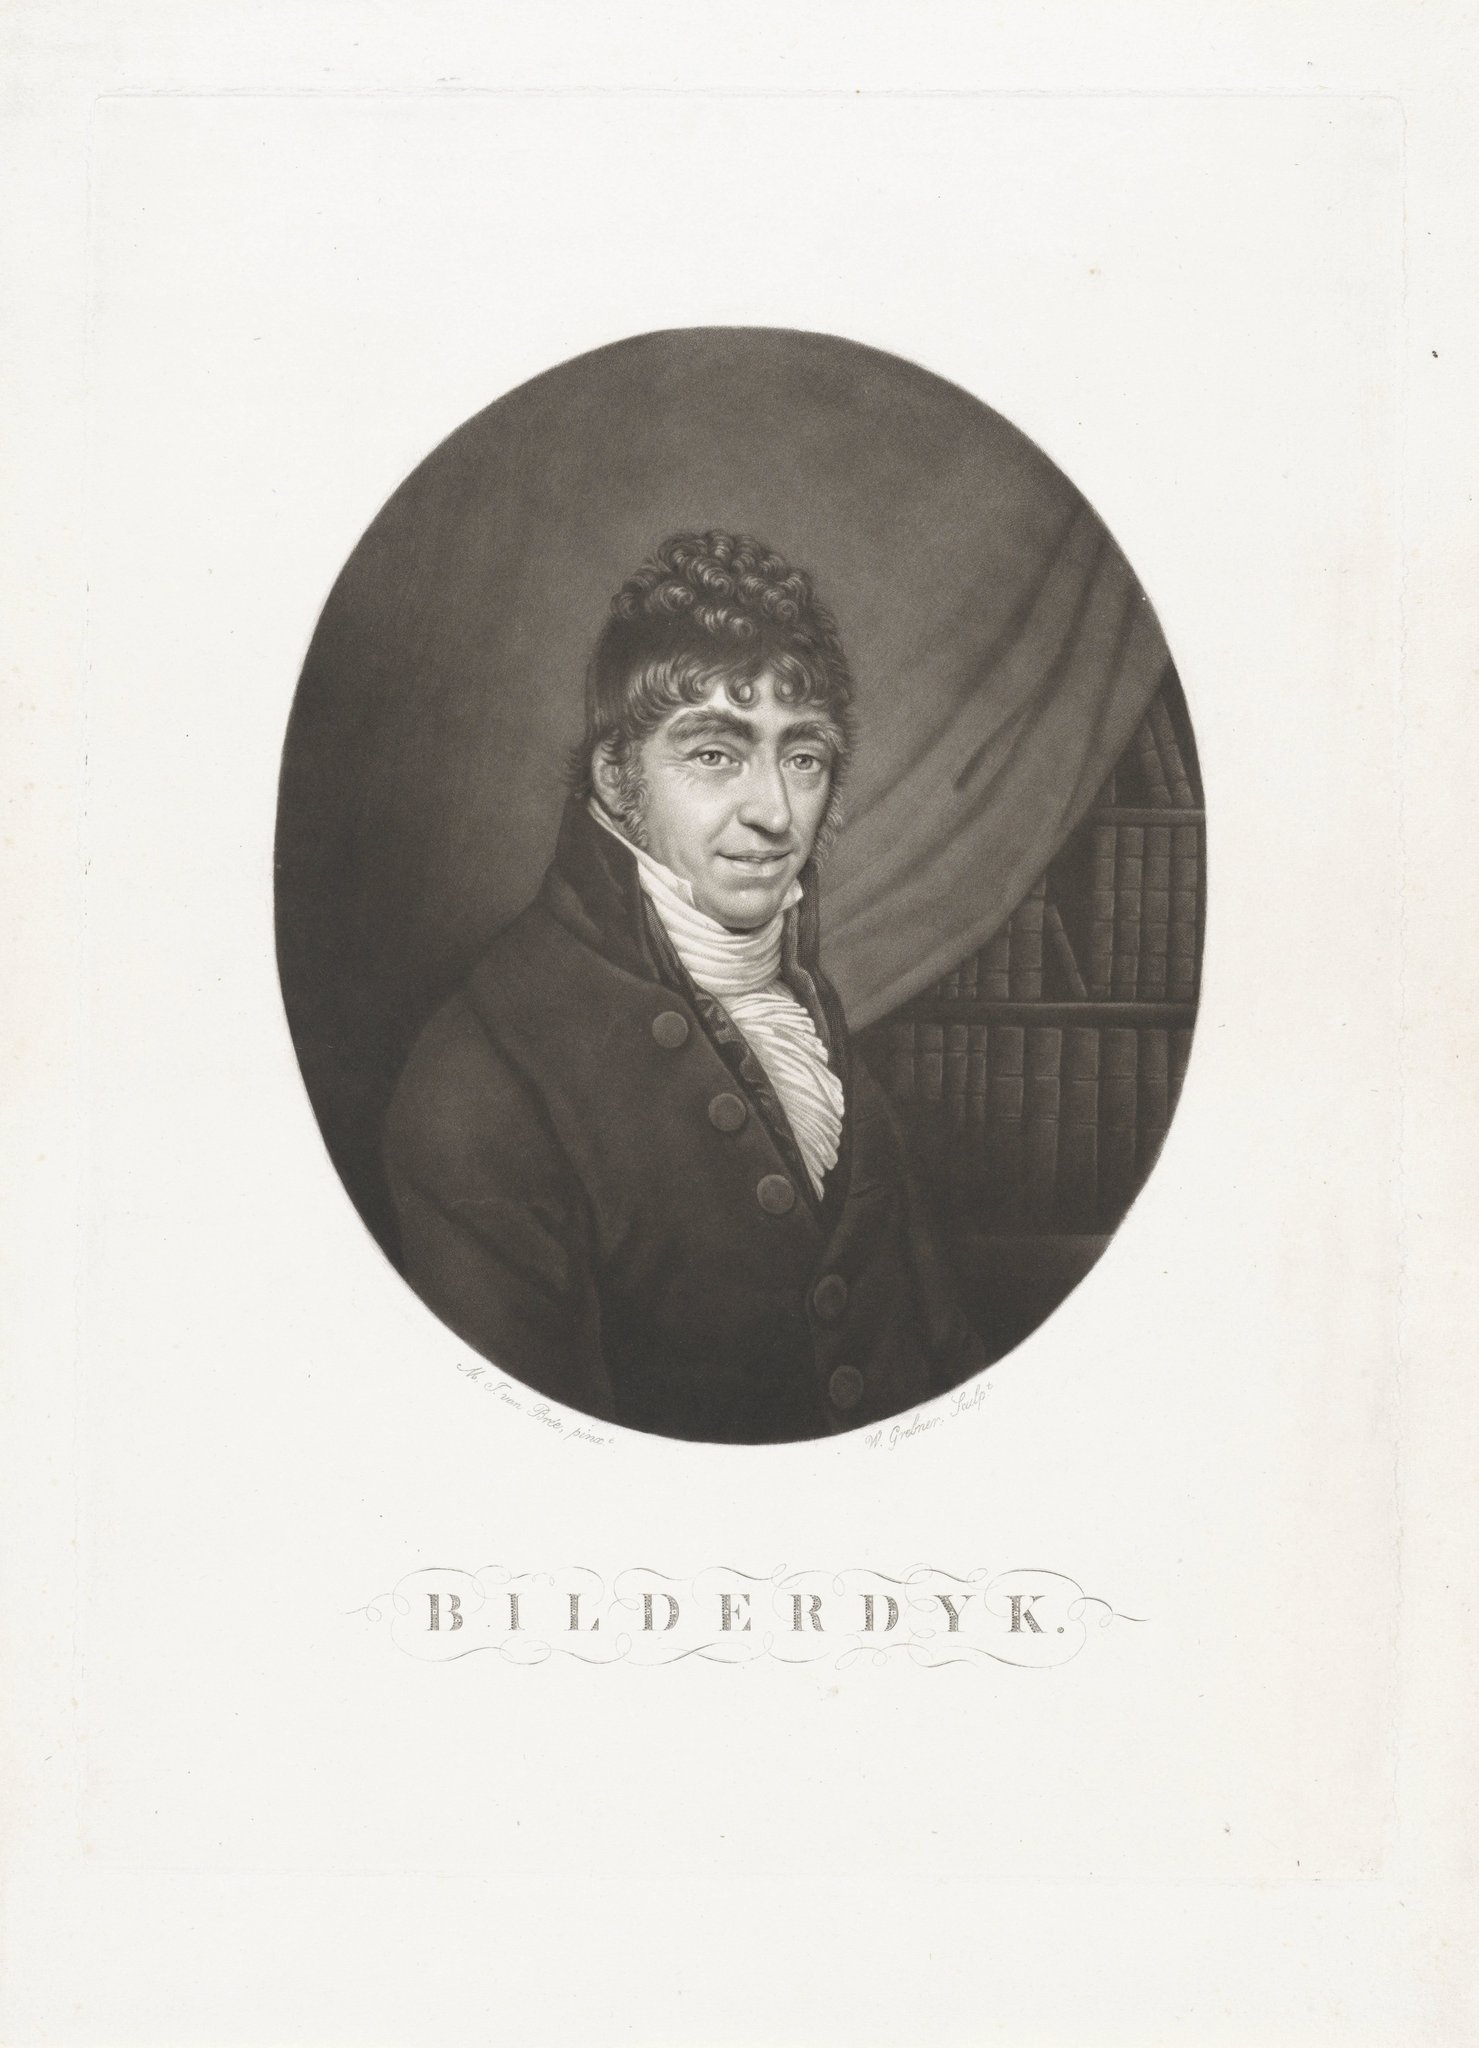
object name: print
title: Portret van Willem Bilderdijk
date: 1794-1866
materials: paper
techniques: engraving, roulette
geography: amsterdam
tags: amsterdam, haarlem, print maker, draughtsman, willem bilderdijk, book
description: De geschiedschrijver, taalkundige, dichter en advocaat Willem Bilderdijk. Op de achtergrond een boekenkast.